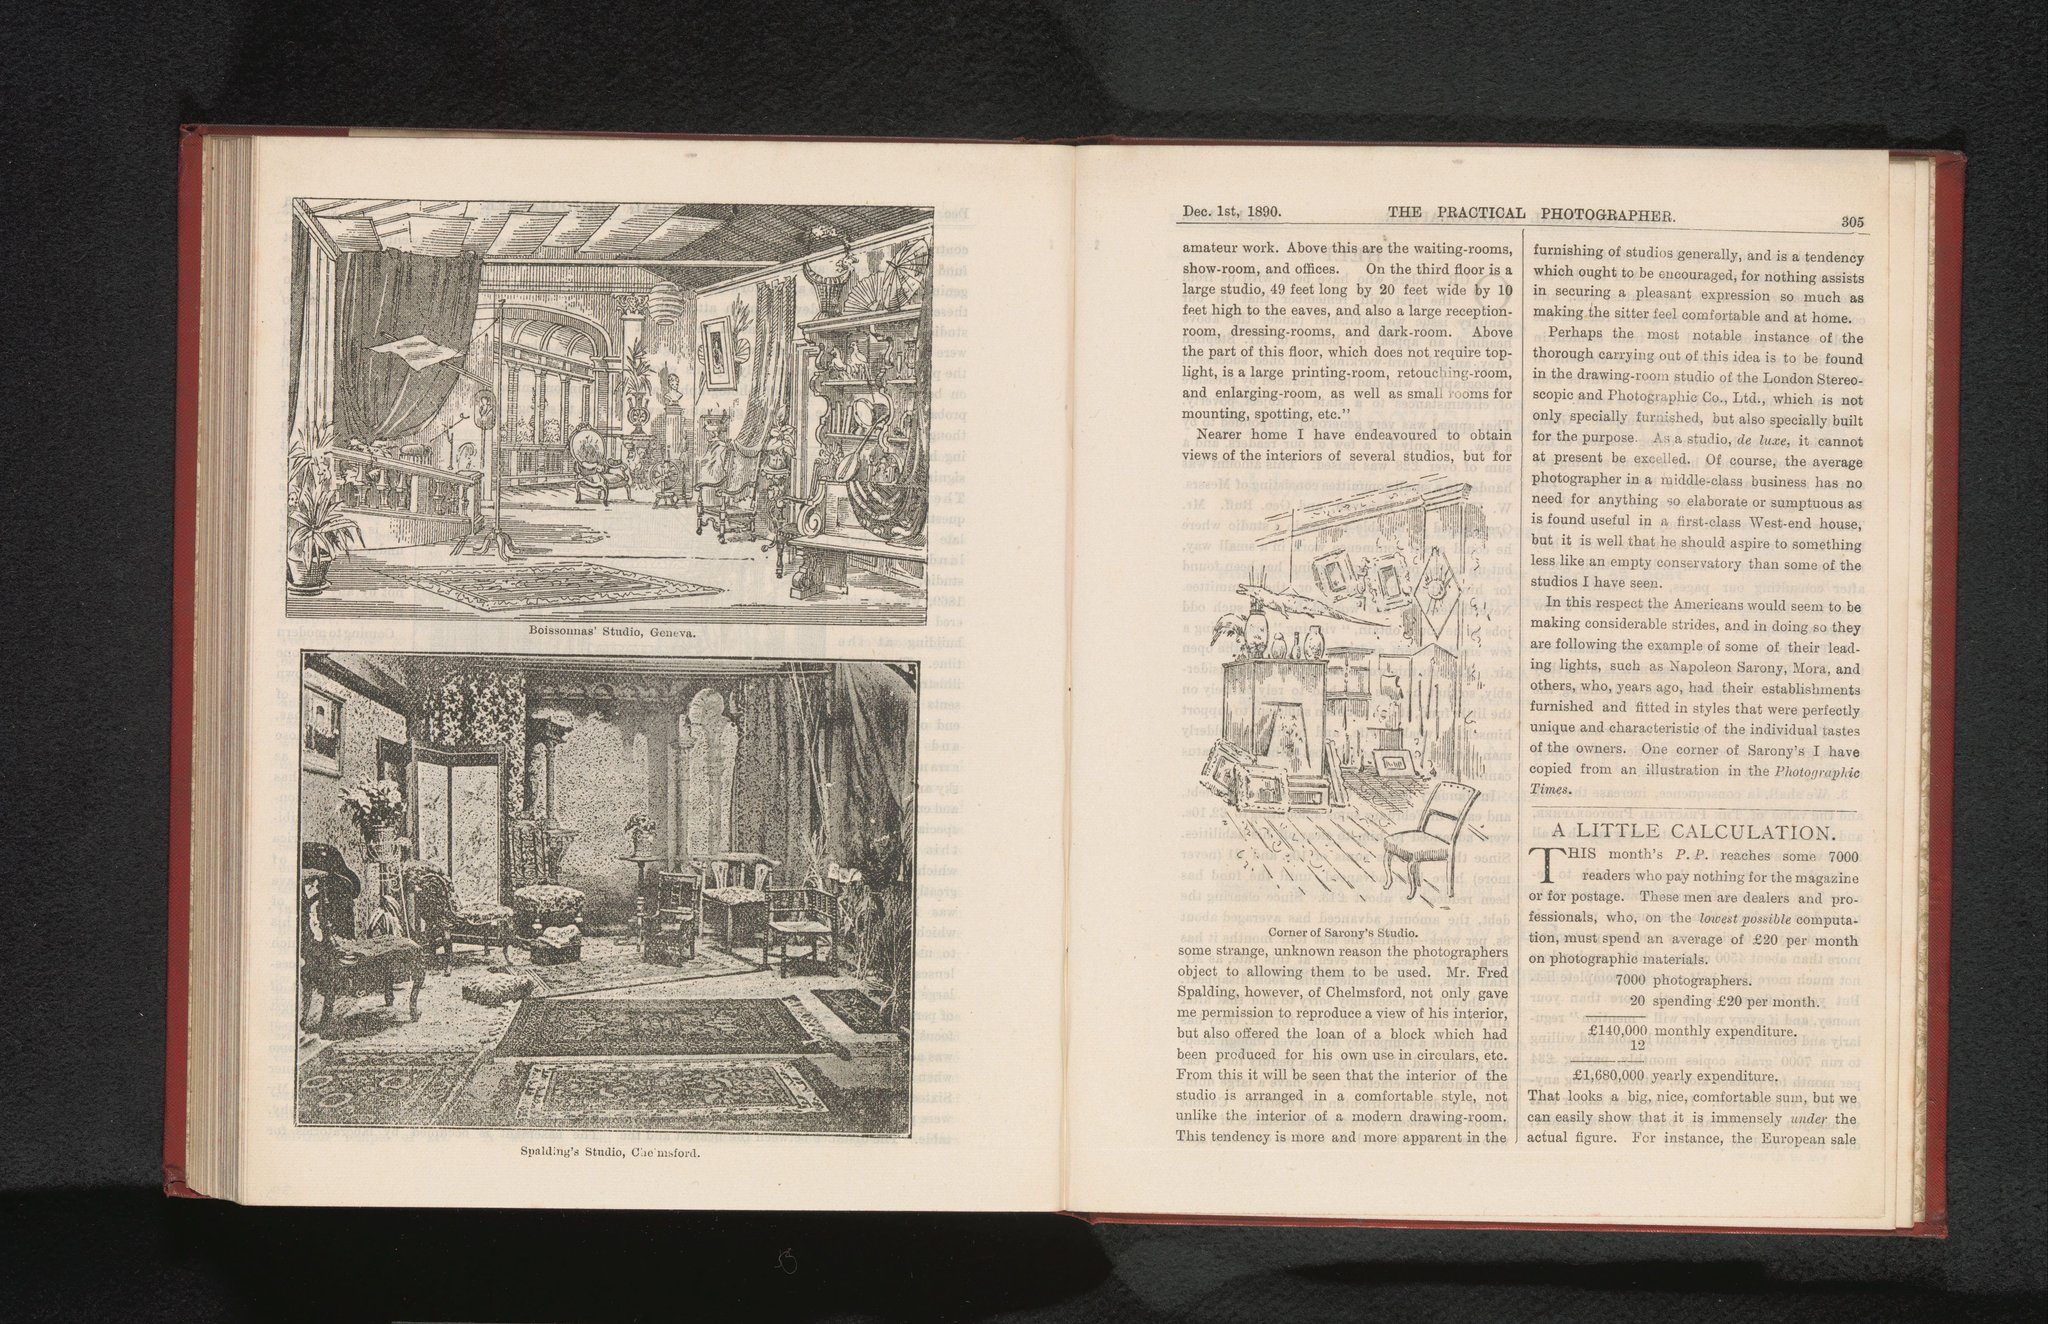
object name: photomechanical print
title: Spalding's Studio, Chelmsford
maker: Anonymous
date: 1885-1890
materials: paper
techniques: autotype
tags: studio ~ photographer